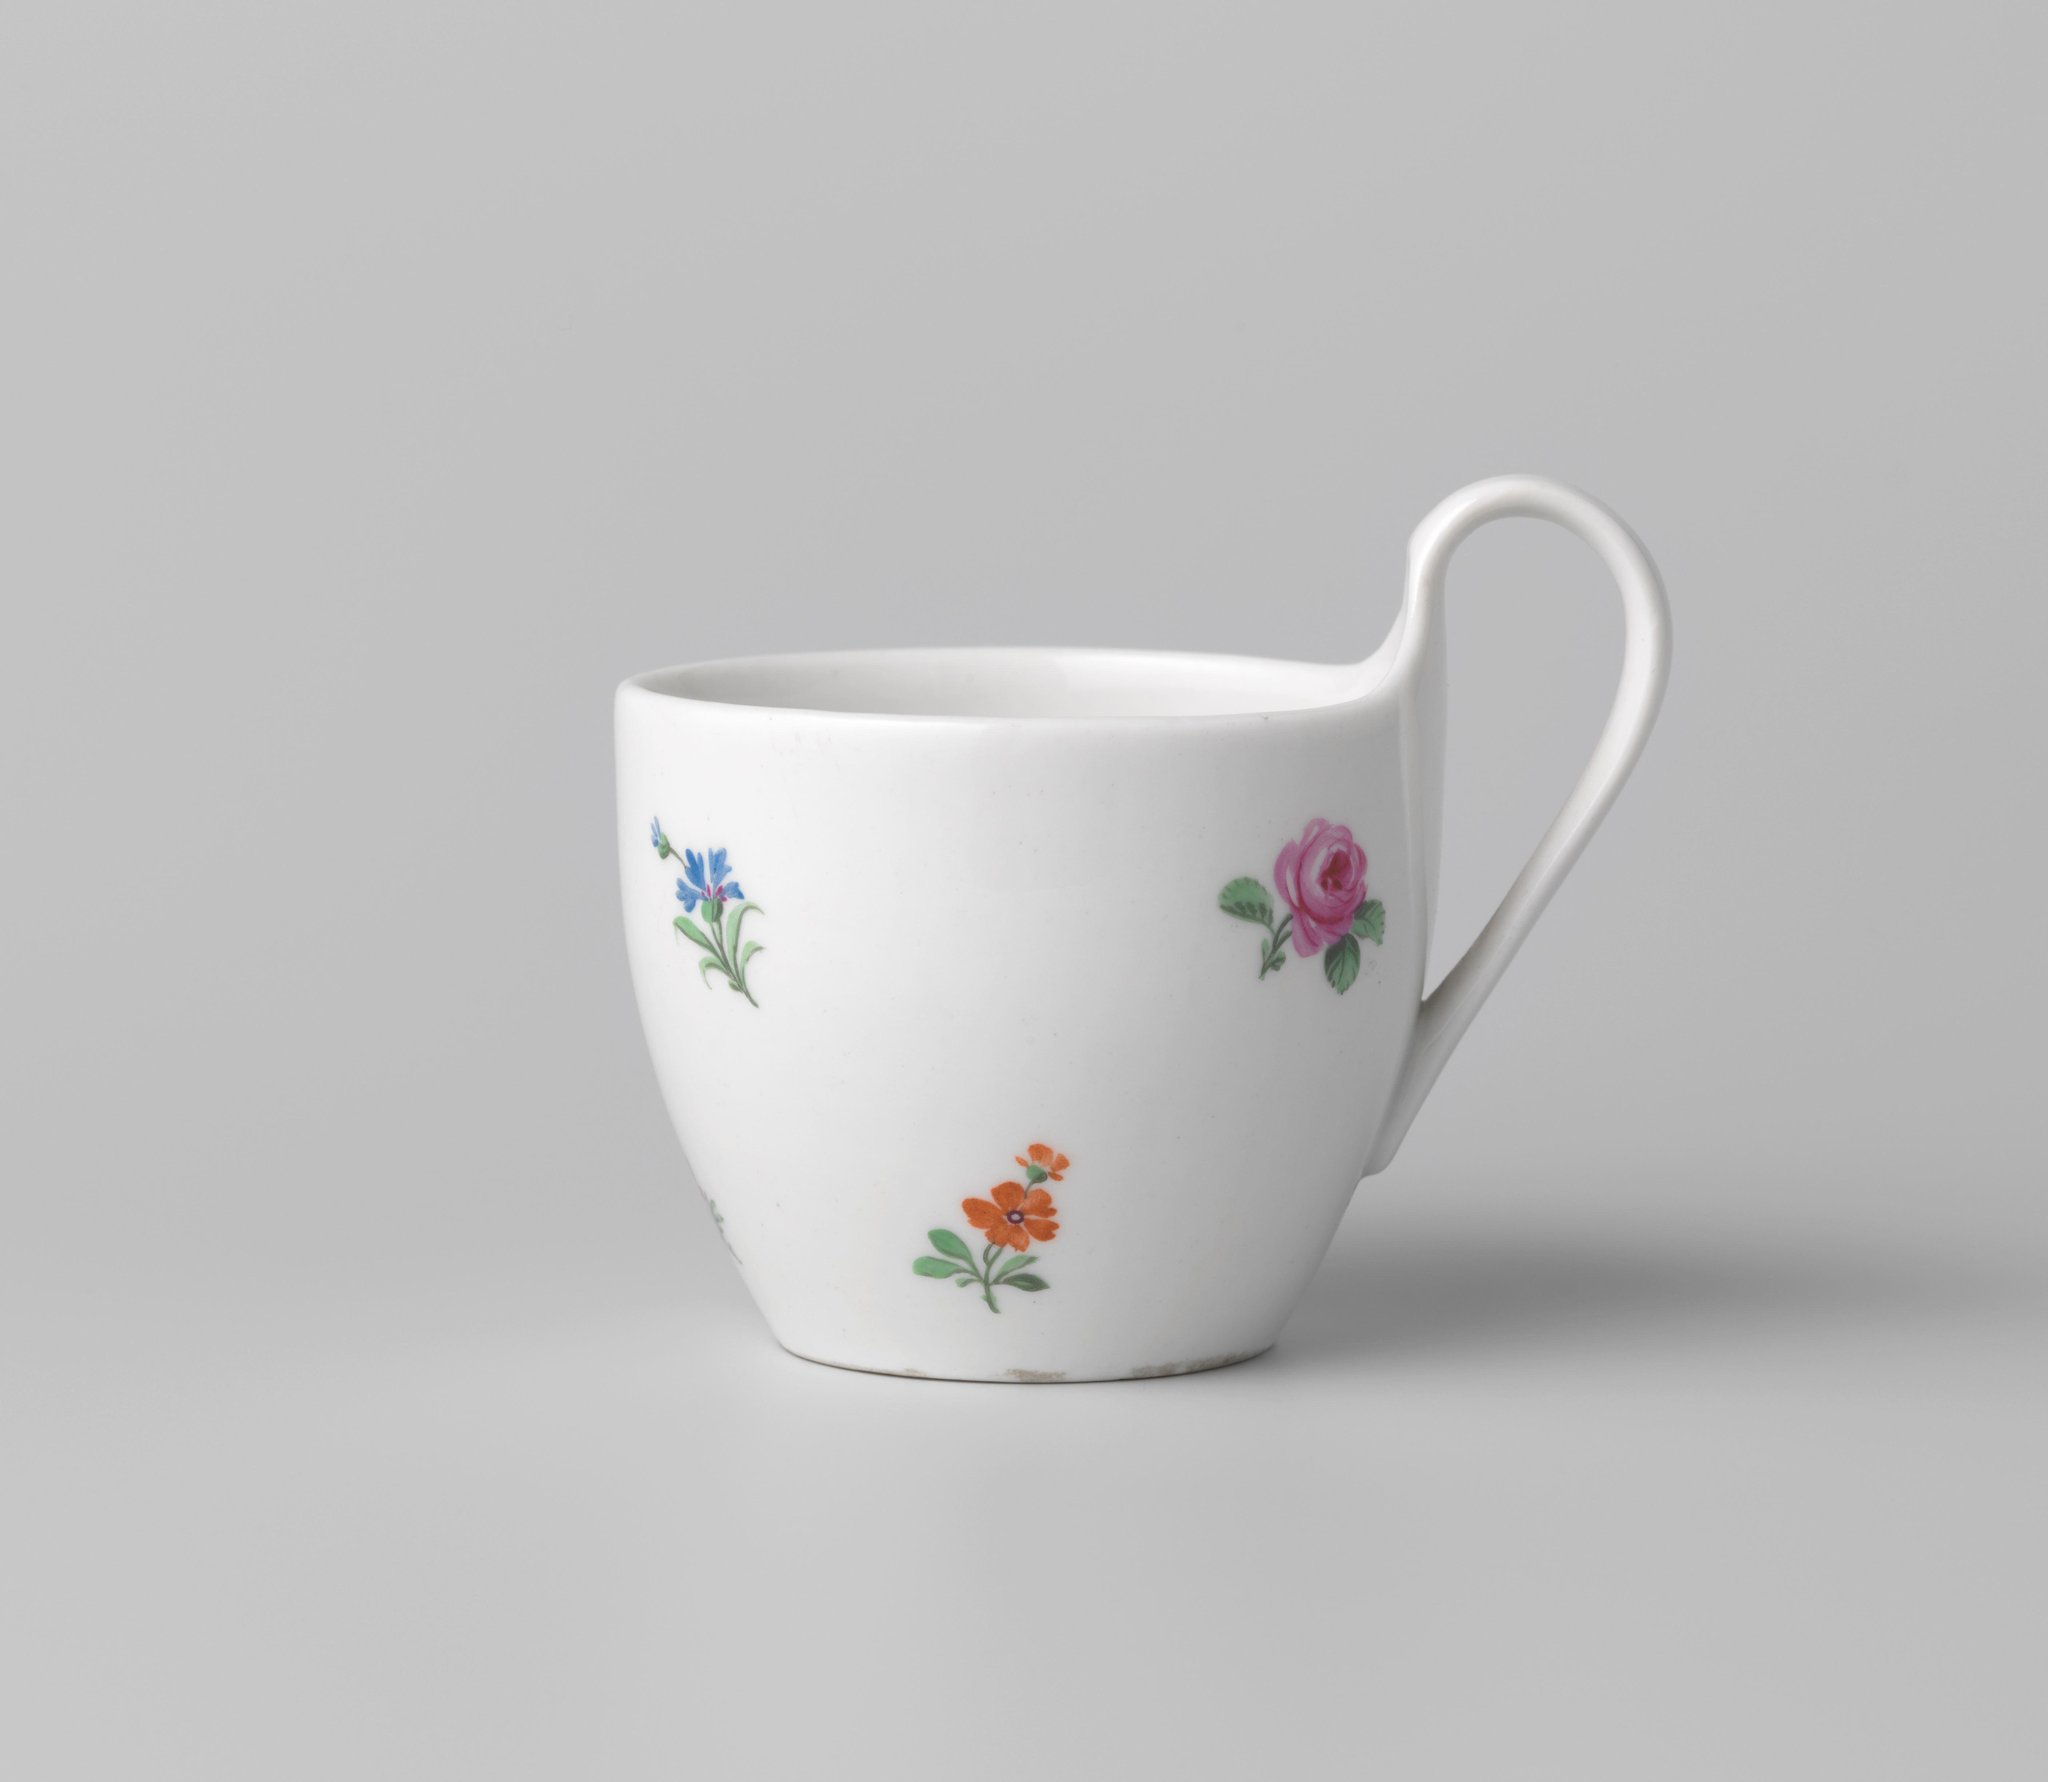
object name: cup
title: Cup with flowers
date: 1849-1870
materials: glaze, paint, porcelain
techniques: firing, turning, vitrification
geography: berlin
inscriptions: mark: ‘scepter met adelaar in medaillon en KOENIGL. PORZELLAN MANUFAKTUR/ II’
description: Kop van porselein, beschilderd op het glazuur in blauw, rood, roze, groen, geel, paars en zwart. Iets ronde wand en hoog, ongelijk C-vormig oor. De buitenwand is bedekt met kleine strooibloemen. De binnenzijde is ongedecoreerd. Gemerkt op de onderzijde met de scepter waaronder een medaillon met de adelaar, een scepter en een globe in zijn klauwen. Het randschrift leest 'KOENIGL. PORZELLAN MANUFAKTUR'. Hierbij II.